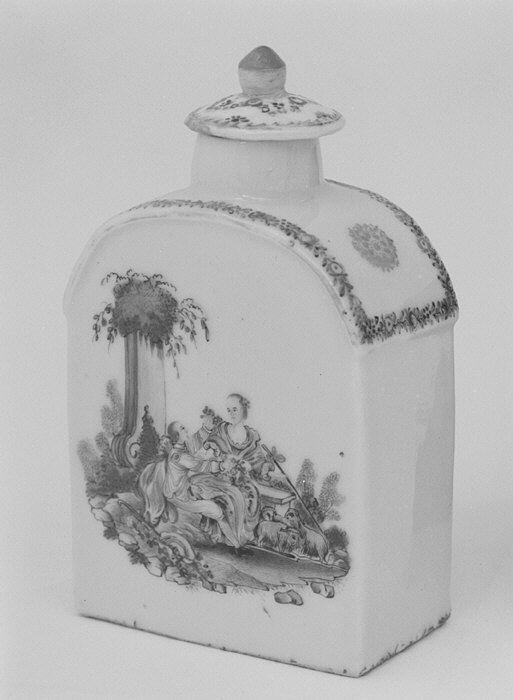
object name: tea caddy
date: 1740-1770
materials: hard paste porcelain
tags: men,women